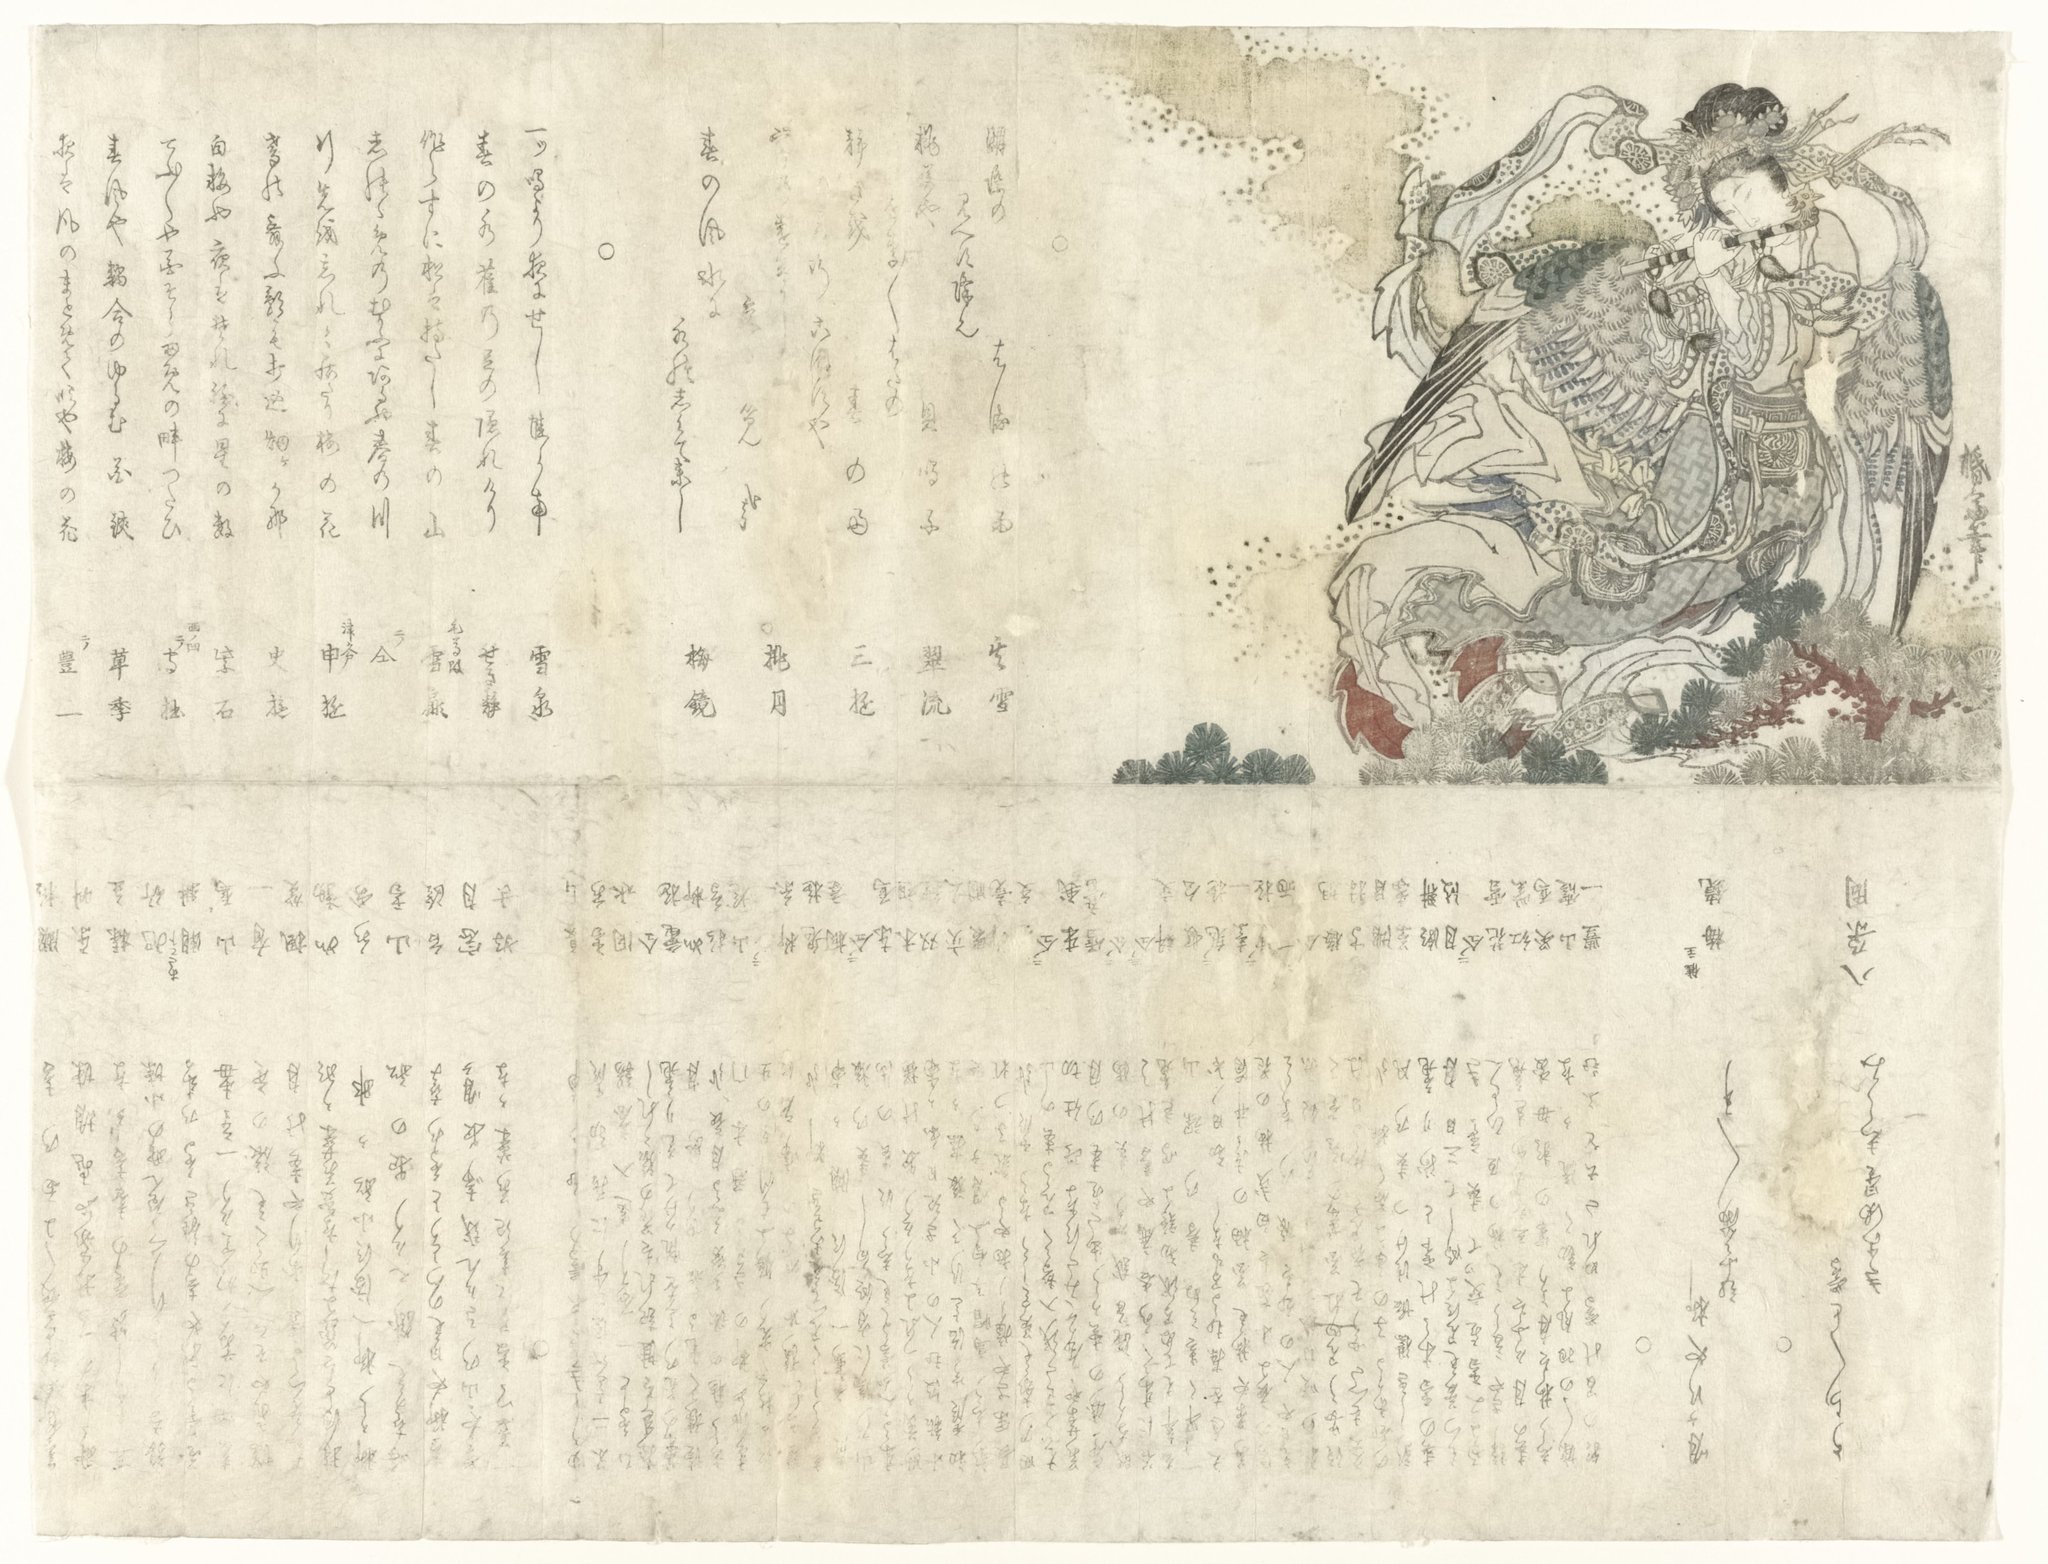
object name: print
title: Woman Playing the Flute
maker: konsai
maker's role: print maker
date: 1840-1850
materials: paper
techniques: woodcut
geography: japan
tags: fabulous beings with wings - aa - female human figure, trees: pine, representations ~ gods, demi-gods, heroes, etc. (hinduism, buddhism, jainism)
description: Een fluitspelende vrouw met vleugels en in Chinese kleding landt in een pijnboom. Deze afbeelding verwijst naar het verhaal van Het Verenkleed (Hagoromo), en komt in veel Oost-Aziatische landen voor. Een Boeddhistisch engel landt in een pijnboom op het strand en doet haar vleugels af. Deze worden door een visser gevonden en terugegeven op voorwaarde dat de engel voor hem danst. Dit doet ze en daarna vliegt ze met haar vleugels weer terug naar huis. Met gedichten door verschillende dichters.